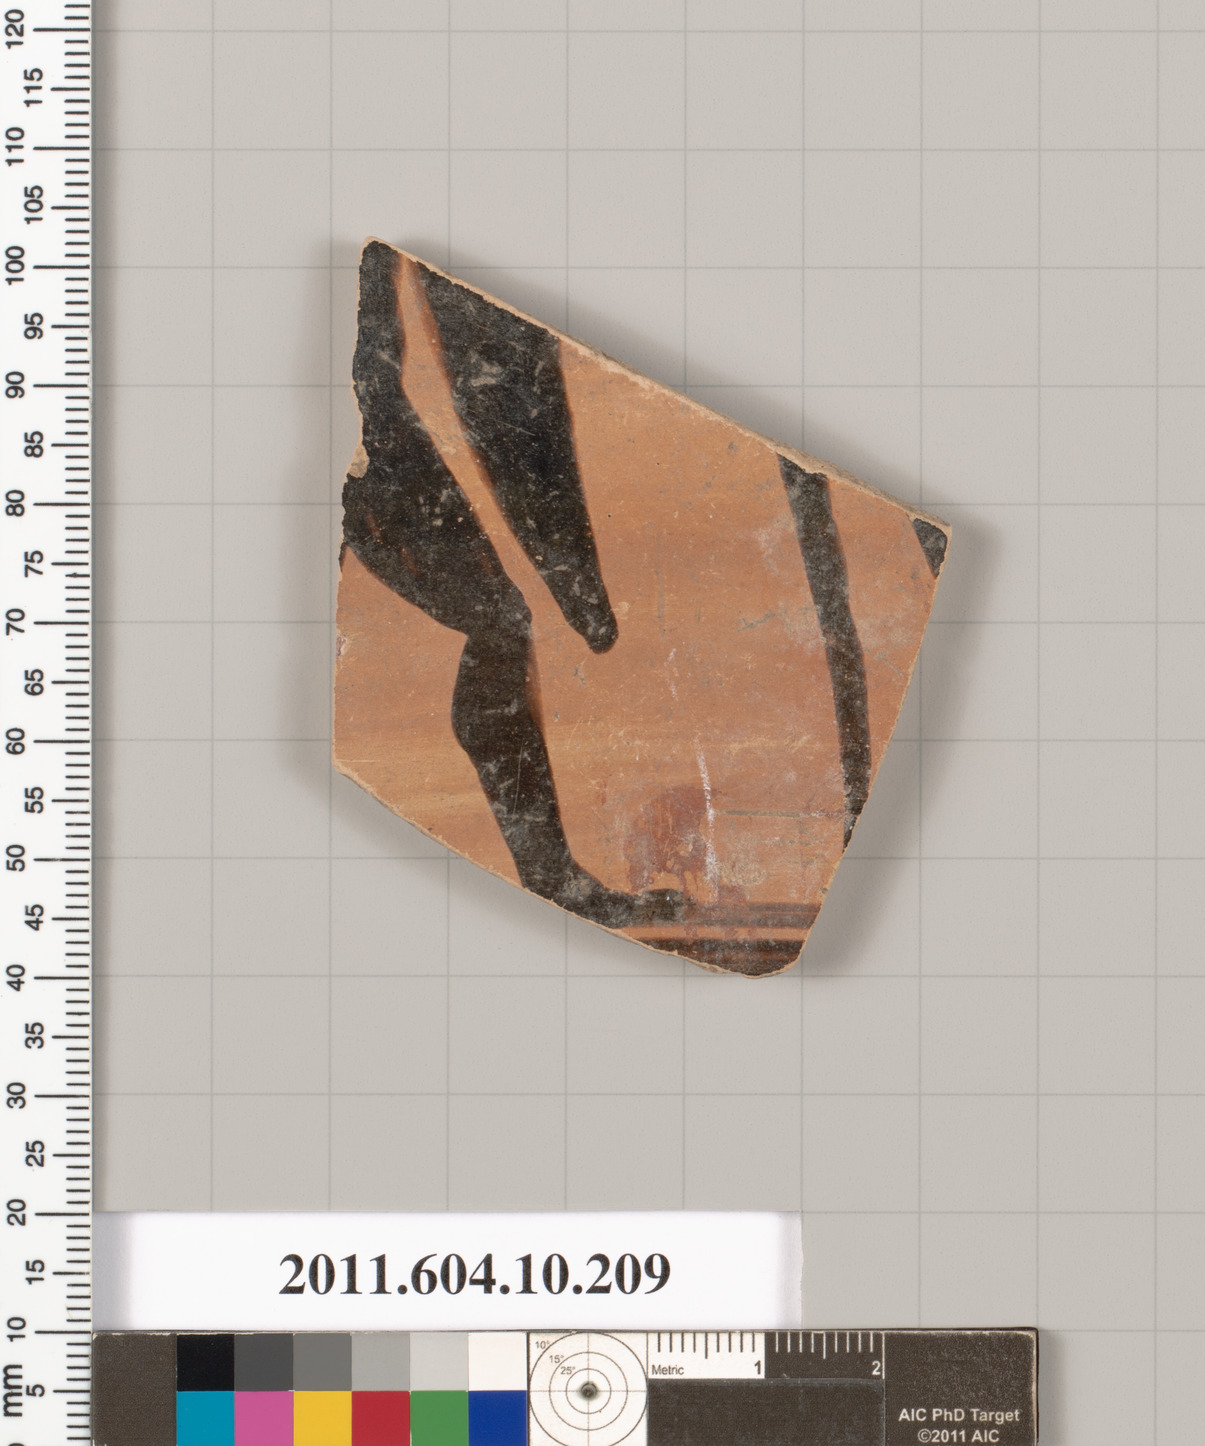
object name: amphora fragment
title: Terracotta fragment of an amphora (jar)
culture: etruscan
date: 600-501 BCE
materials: terracotta